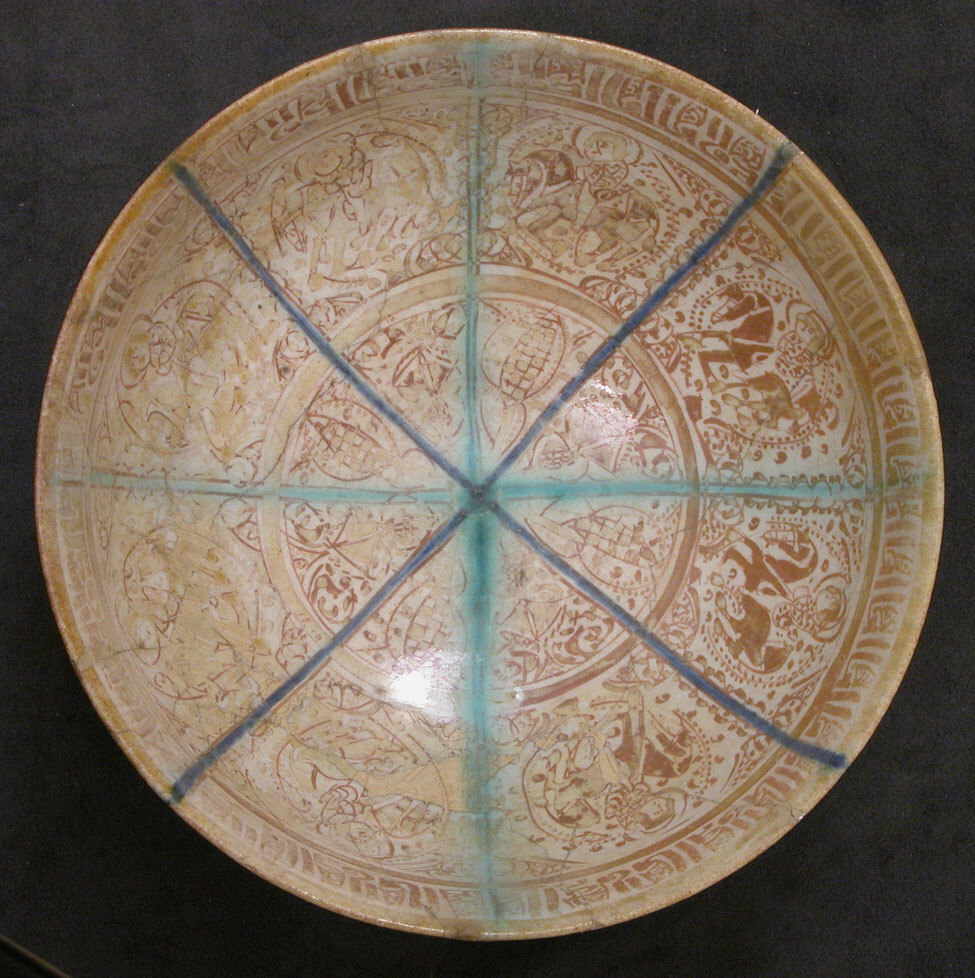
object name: bowl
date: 1101-1300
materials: stonepaste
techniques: glazing, luster painting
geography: iran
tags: men,horses